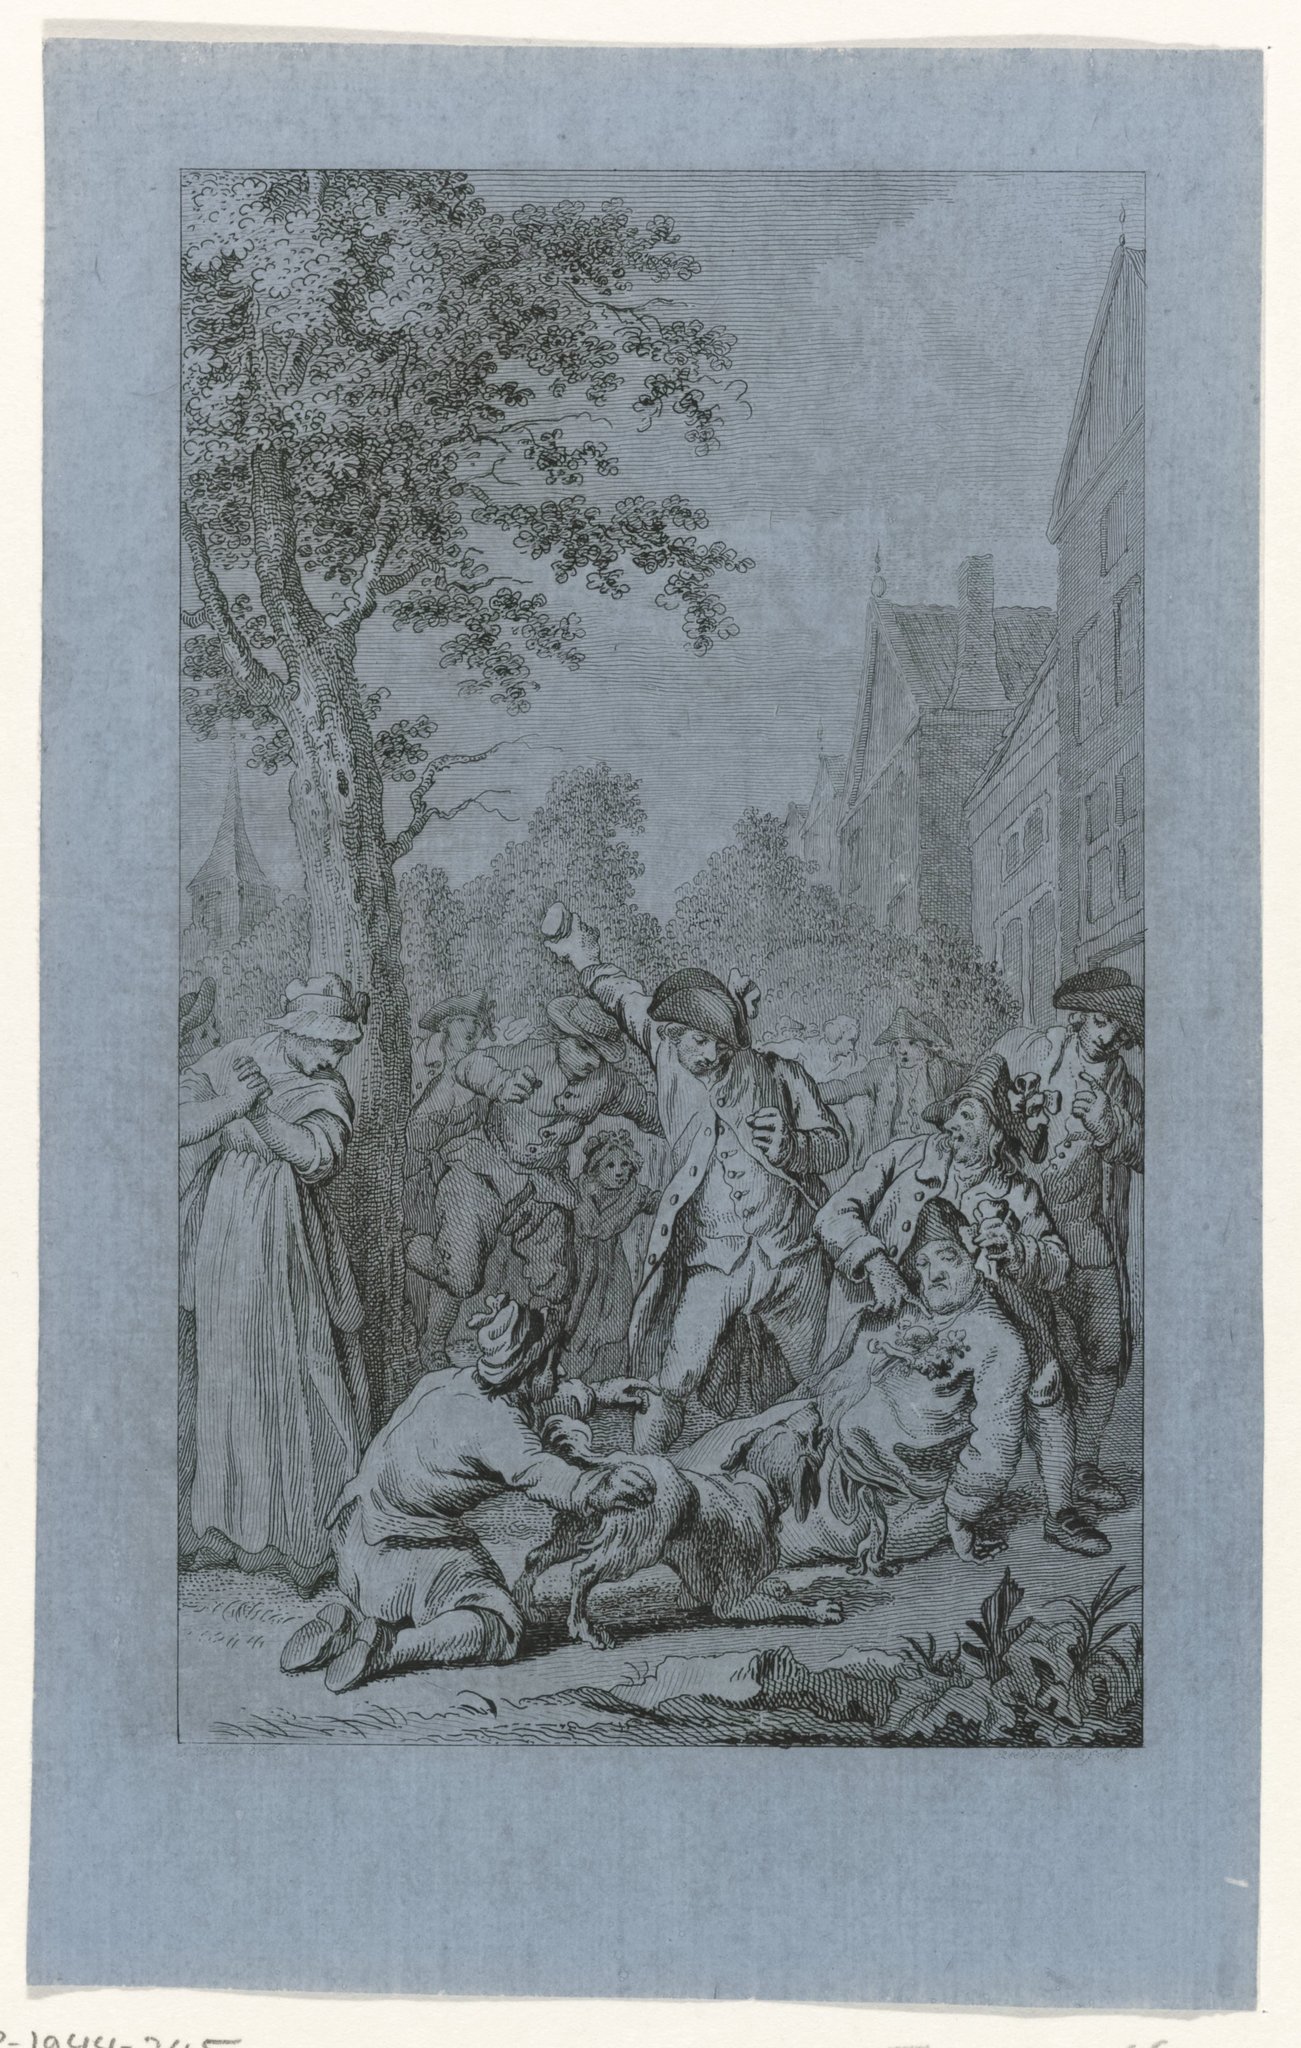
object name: print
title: Mishandeling van het lijk van predikant P. van den Bosch te Zoetermeer, 1787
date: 1798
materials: paper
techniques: engraving, etching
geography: northern netherlands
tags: violation of the corpse, patriots (1780-1795)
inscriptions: collector's mark: Lugt 2228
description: Gebruikt als illustratie in: P.A. Loosjes. Vaderlandsche historie, vervattende de geschiedenissen, der Vereenigde Nederlanden (...). Ten onmiddelyken vervolge van Wagenaar's Vaderlandsche historie. Amsterdam: Johannes Allart, dl. 20.